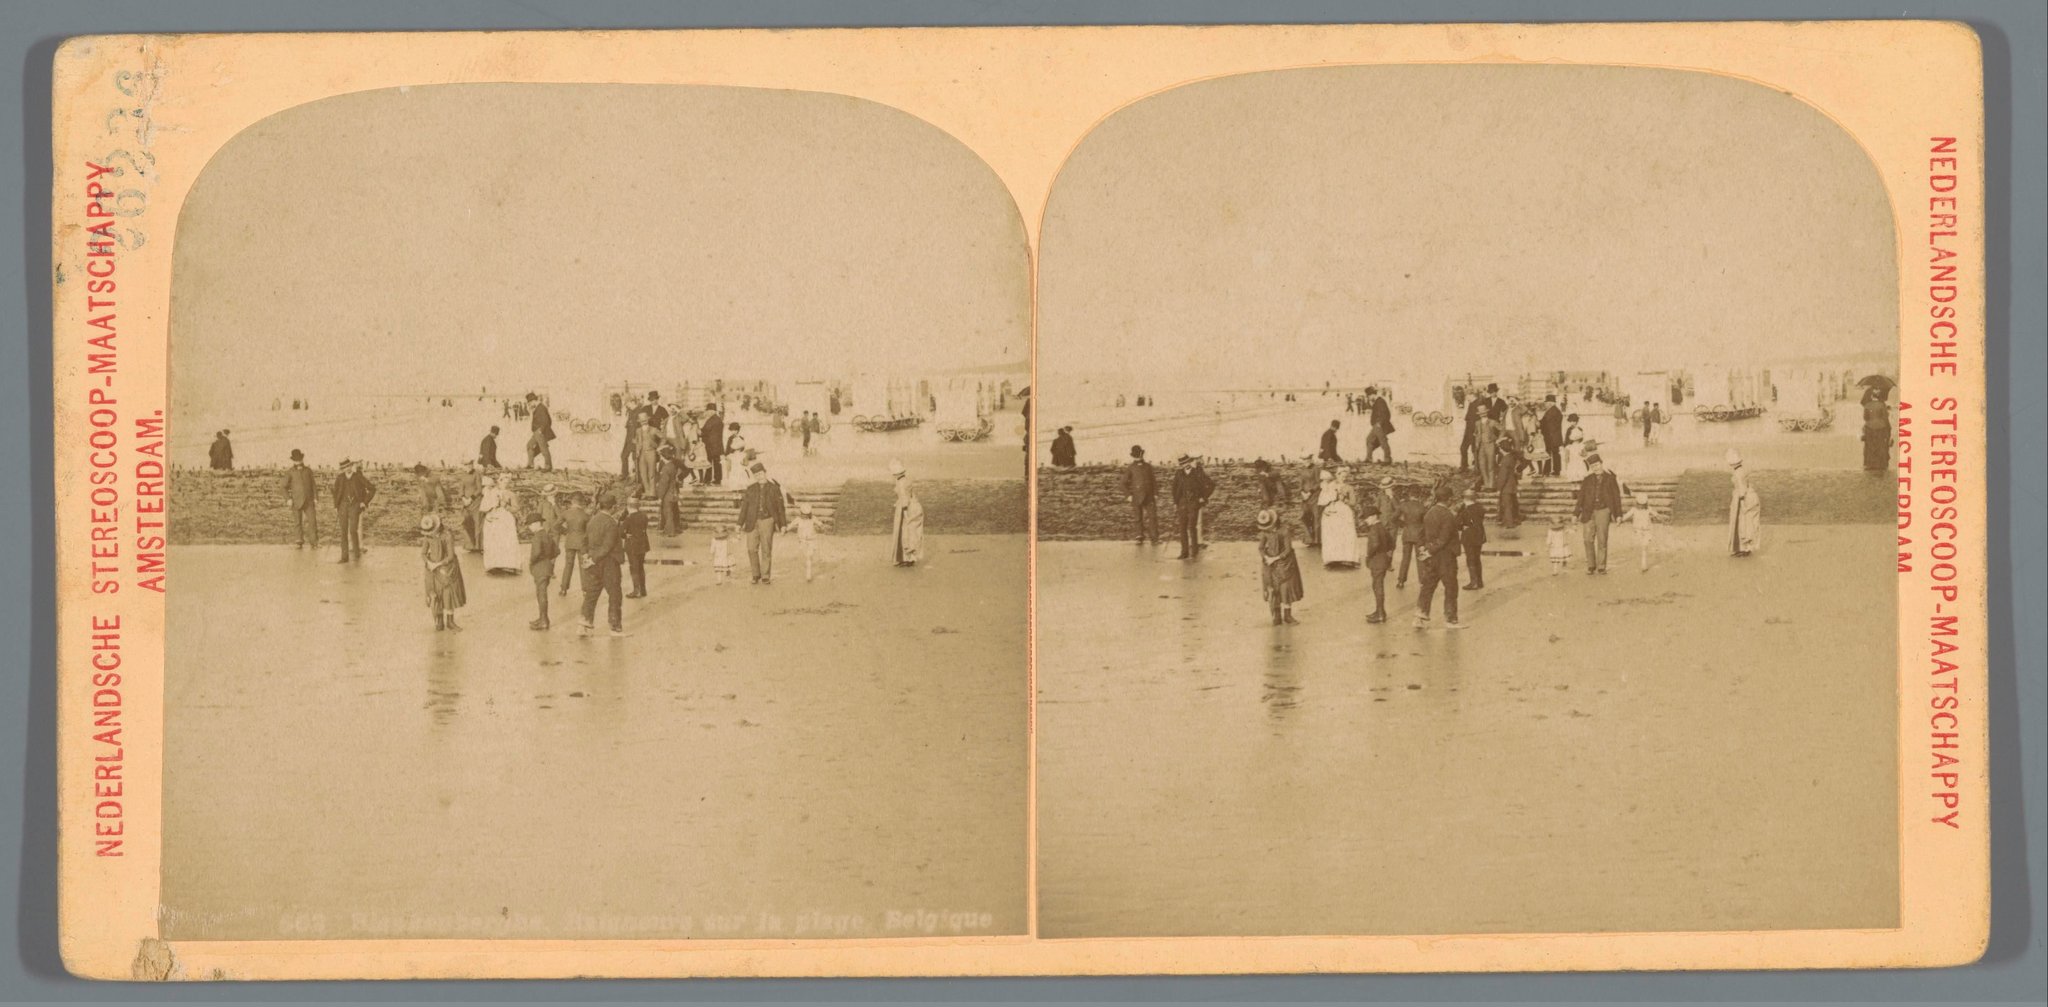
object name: stereograph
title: Blankenberghe. Baigneurs sur la plage, Belgique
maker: j.g. beers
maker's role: fotograaf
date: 1873-1890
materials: cardboard, paper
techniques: albumen print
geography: amsterdam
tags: beach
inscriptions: number: ‘26236’